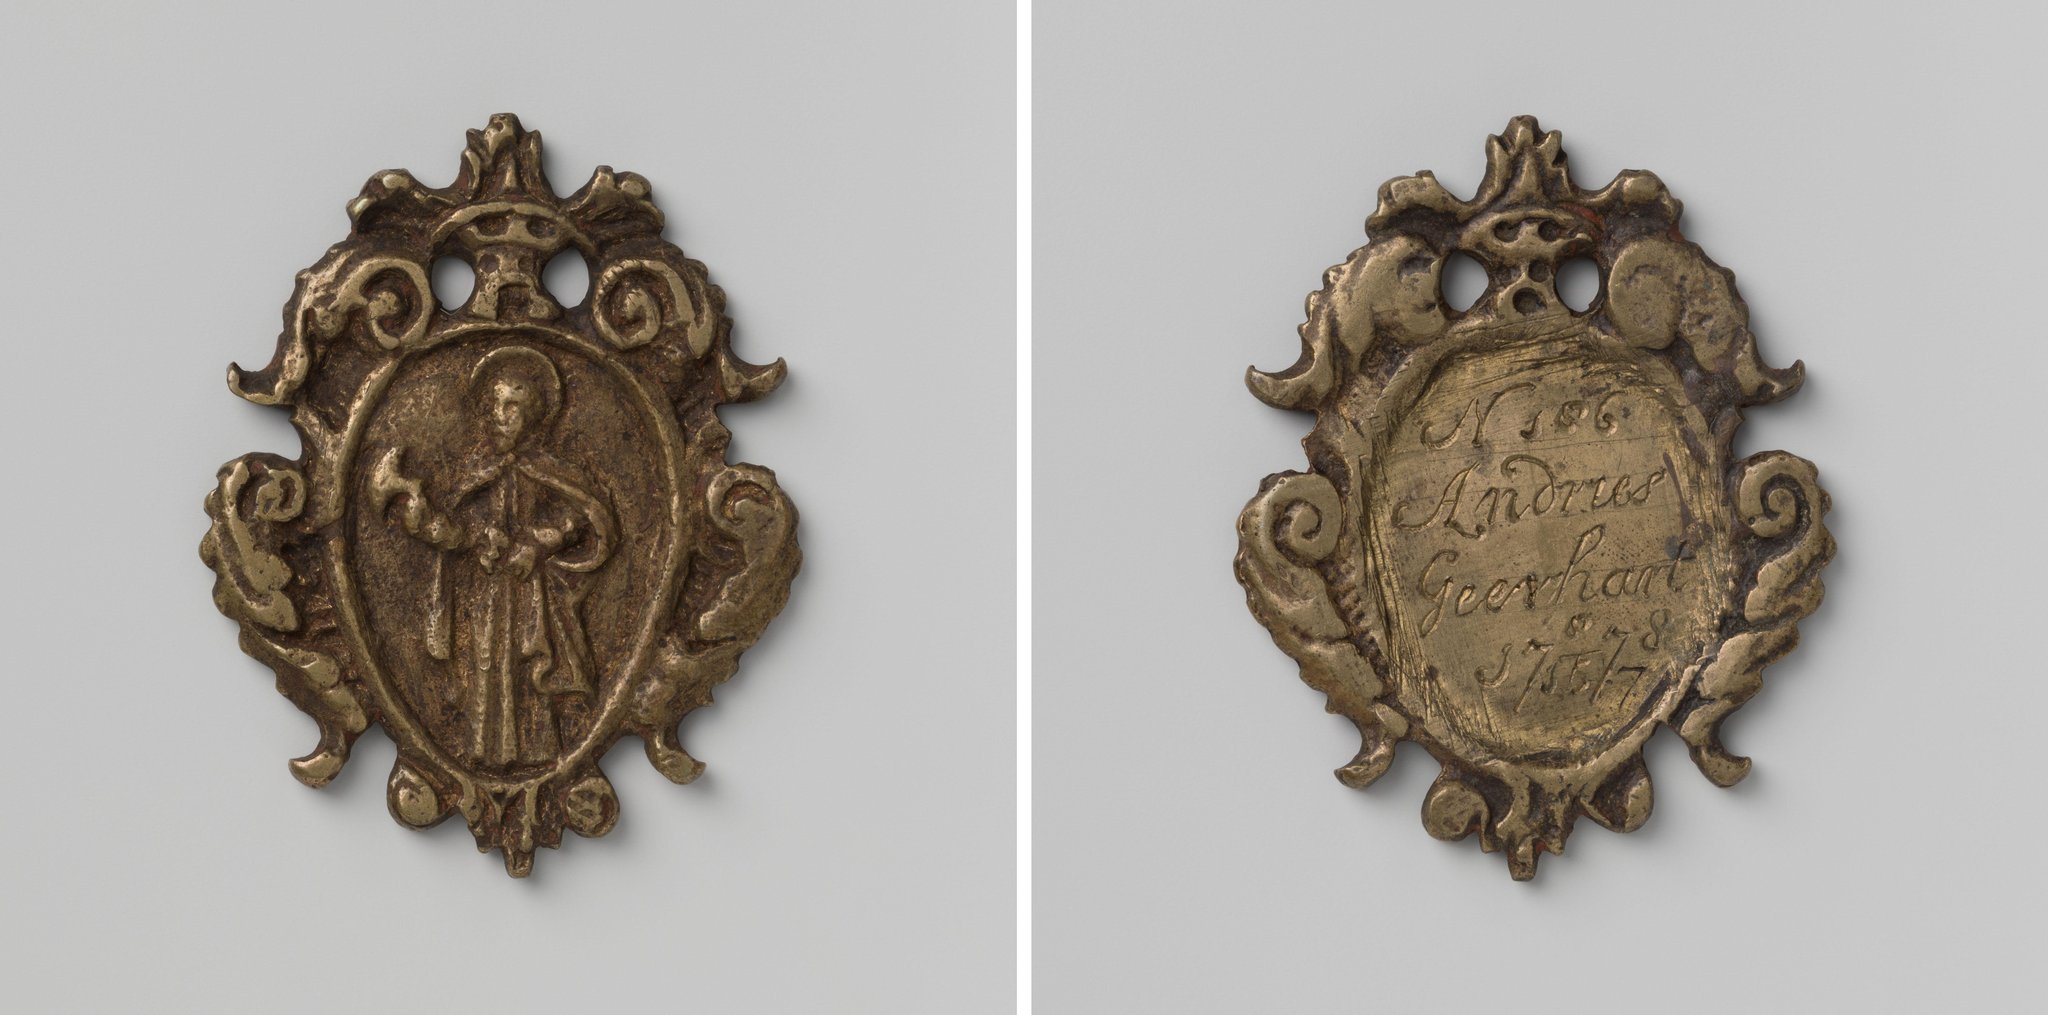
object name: medal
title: Huidekopers-, leerlooiers- en schoenmakersgilde van Alkmaar, gildepenning van Andries Geerhart met no. 186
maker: Anonymous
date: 1778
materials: brass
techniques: casting, engraving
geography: alkmaar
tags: andries geerhart, alkmaar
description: Onregelmatige messing penning, bestaande uit eivormig schild, omgeven door cartouche van bladerwerk. Voorzijde: St. Crispinus met schoenmakersmes in rechter- en plooi van zijn mantel in linkerhand. Keerzijde: opschrift.